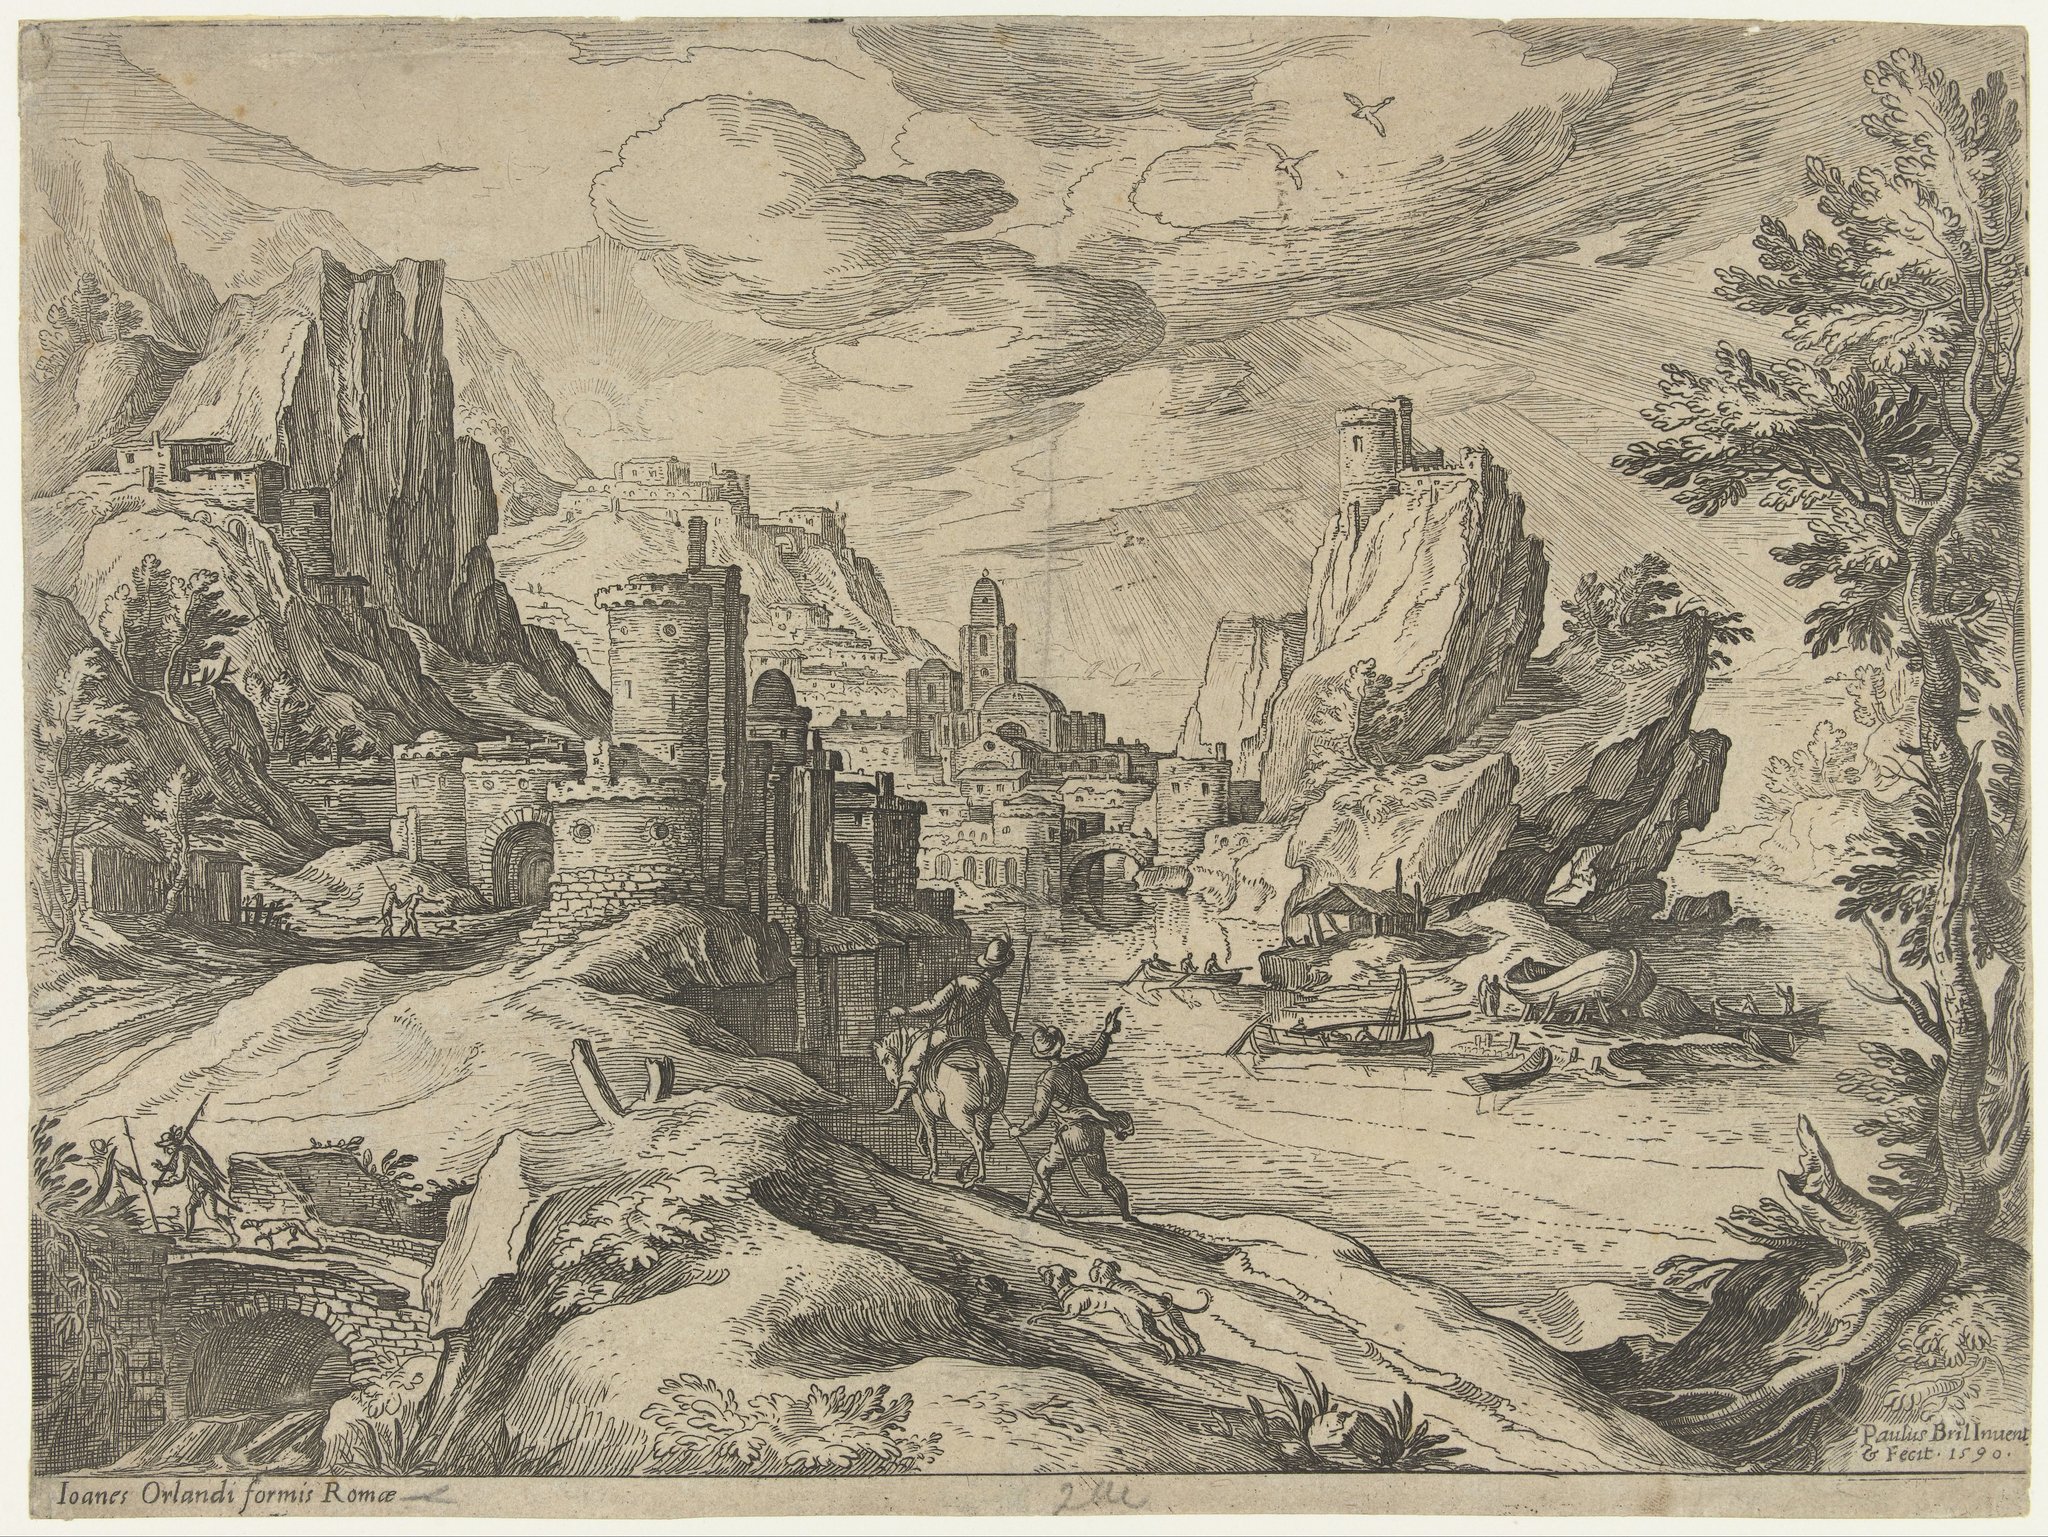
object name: print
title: Rotskust in Campania met stad en reizigers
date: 1590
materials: paper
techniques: etching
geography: rome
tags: rocky coast, campania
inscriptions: collector's mark: Lugt 2228a, collector's mark: Lugt 2228